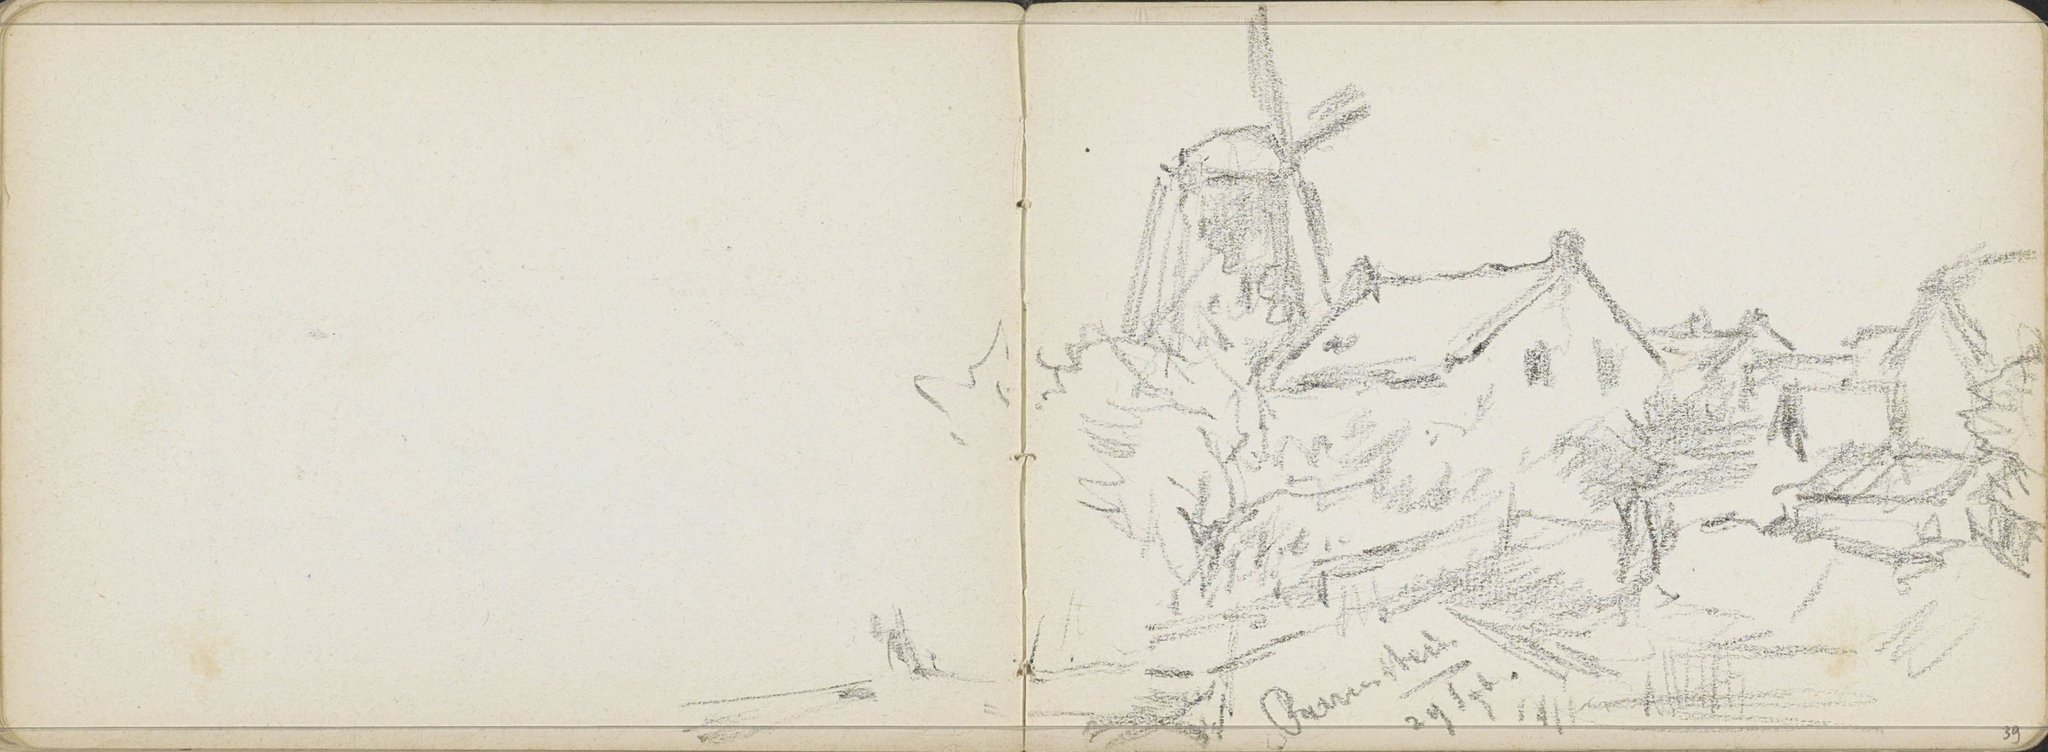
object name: sketchbook leaf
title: Molen te Ravenstein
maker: willem cornelis rip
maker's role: draughtsman, painter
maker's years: 1856-1922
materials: chalk, paper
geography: ravenstein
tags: village, windmill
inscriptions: date and inscription: ‘Ravenstein/ 29 Sep.’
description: Blad 38 verso en 39 recto uit een schetsboek met 42 bladen.